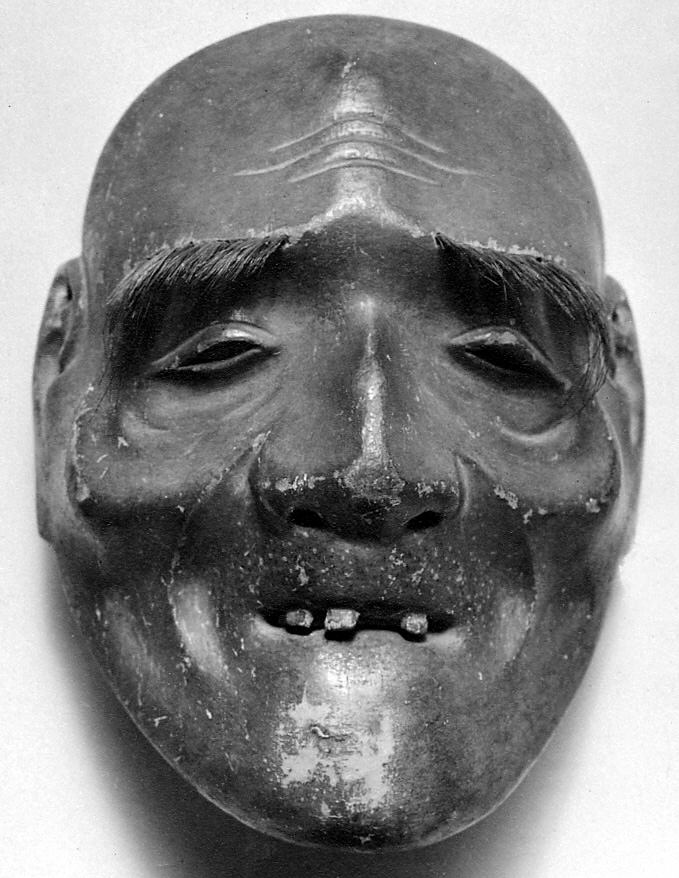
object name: kyogen mask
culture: japanese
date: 1701-1800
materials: wood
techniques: brocade, carving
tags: masks